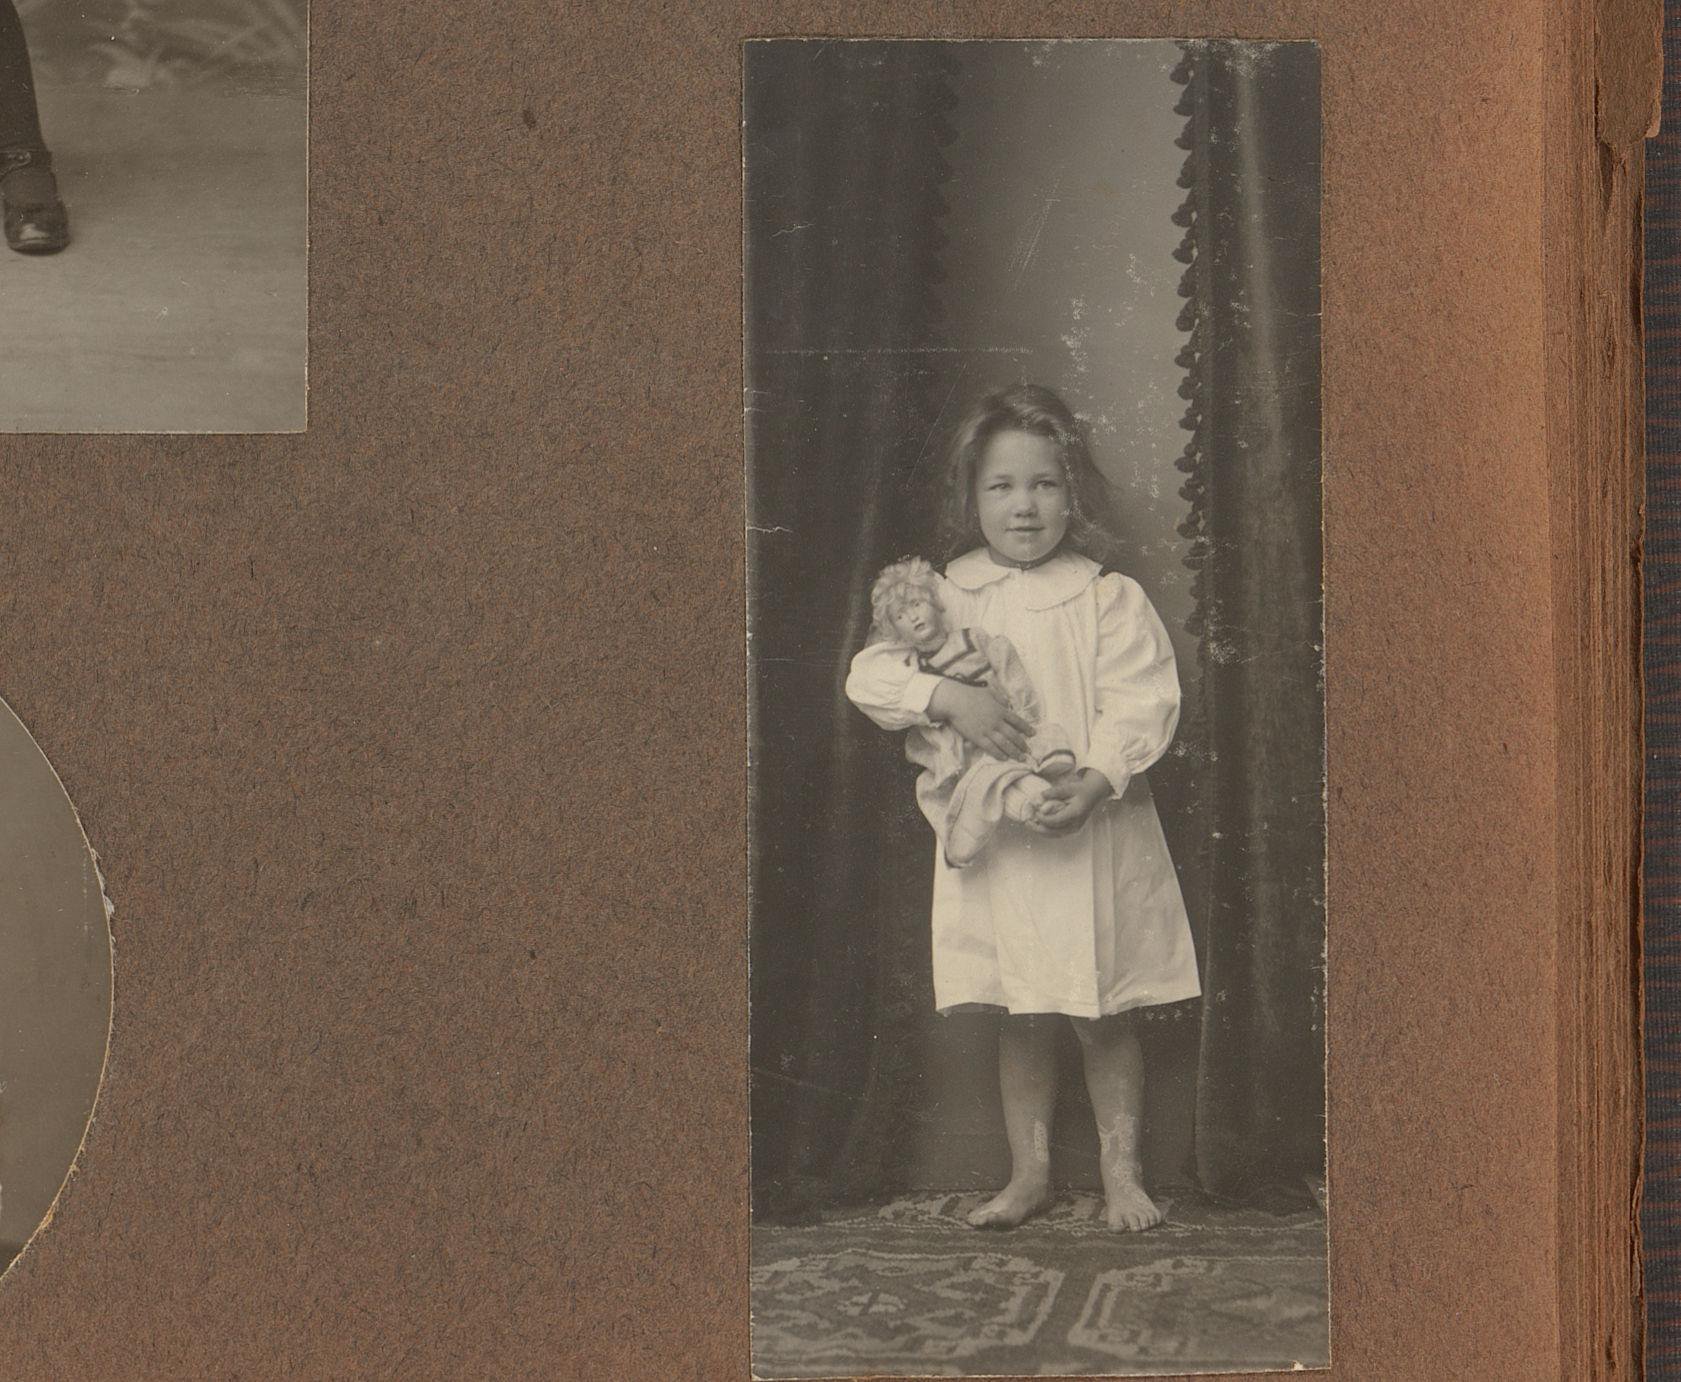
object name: photograph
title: Studioportret Thea Diepenbrock met pop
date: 1912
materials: photographic support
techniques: photography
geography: amsterdam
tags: pianist, thea diepenbrock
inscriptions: date: ‘1912.’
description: Foto op bruin albumblad 17 van familiealbum van Alphons Diepenbrock.